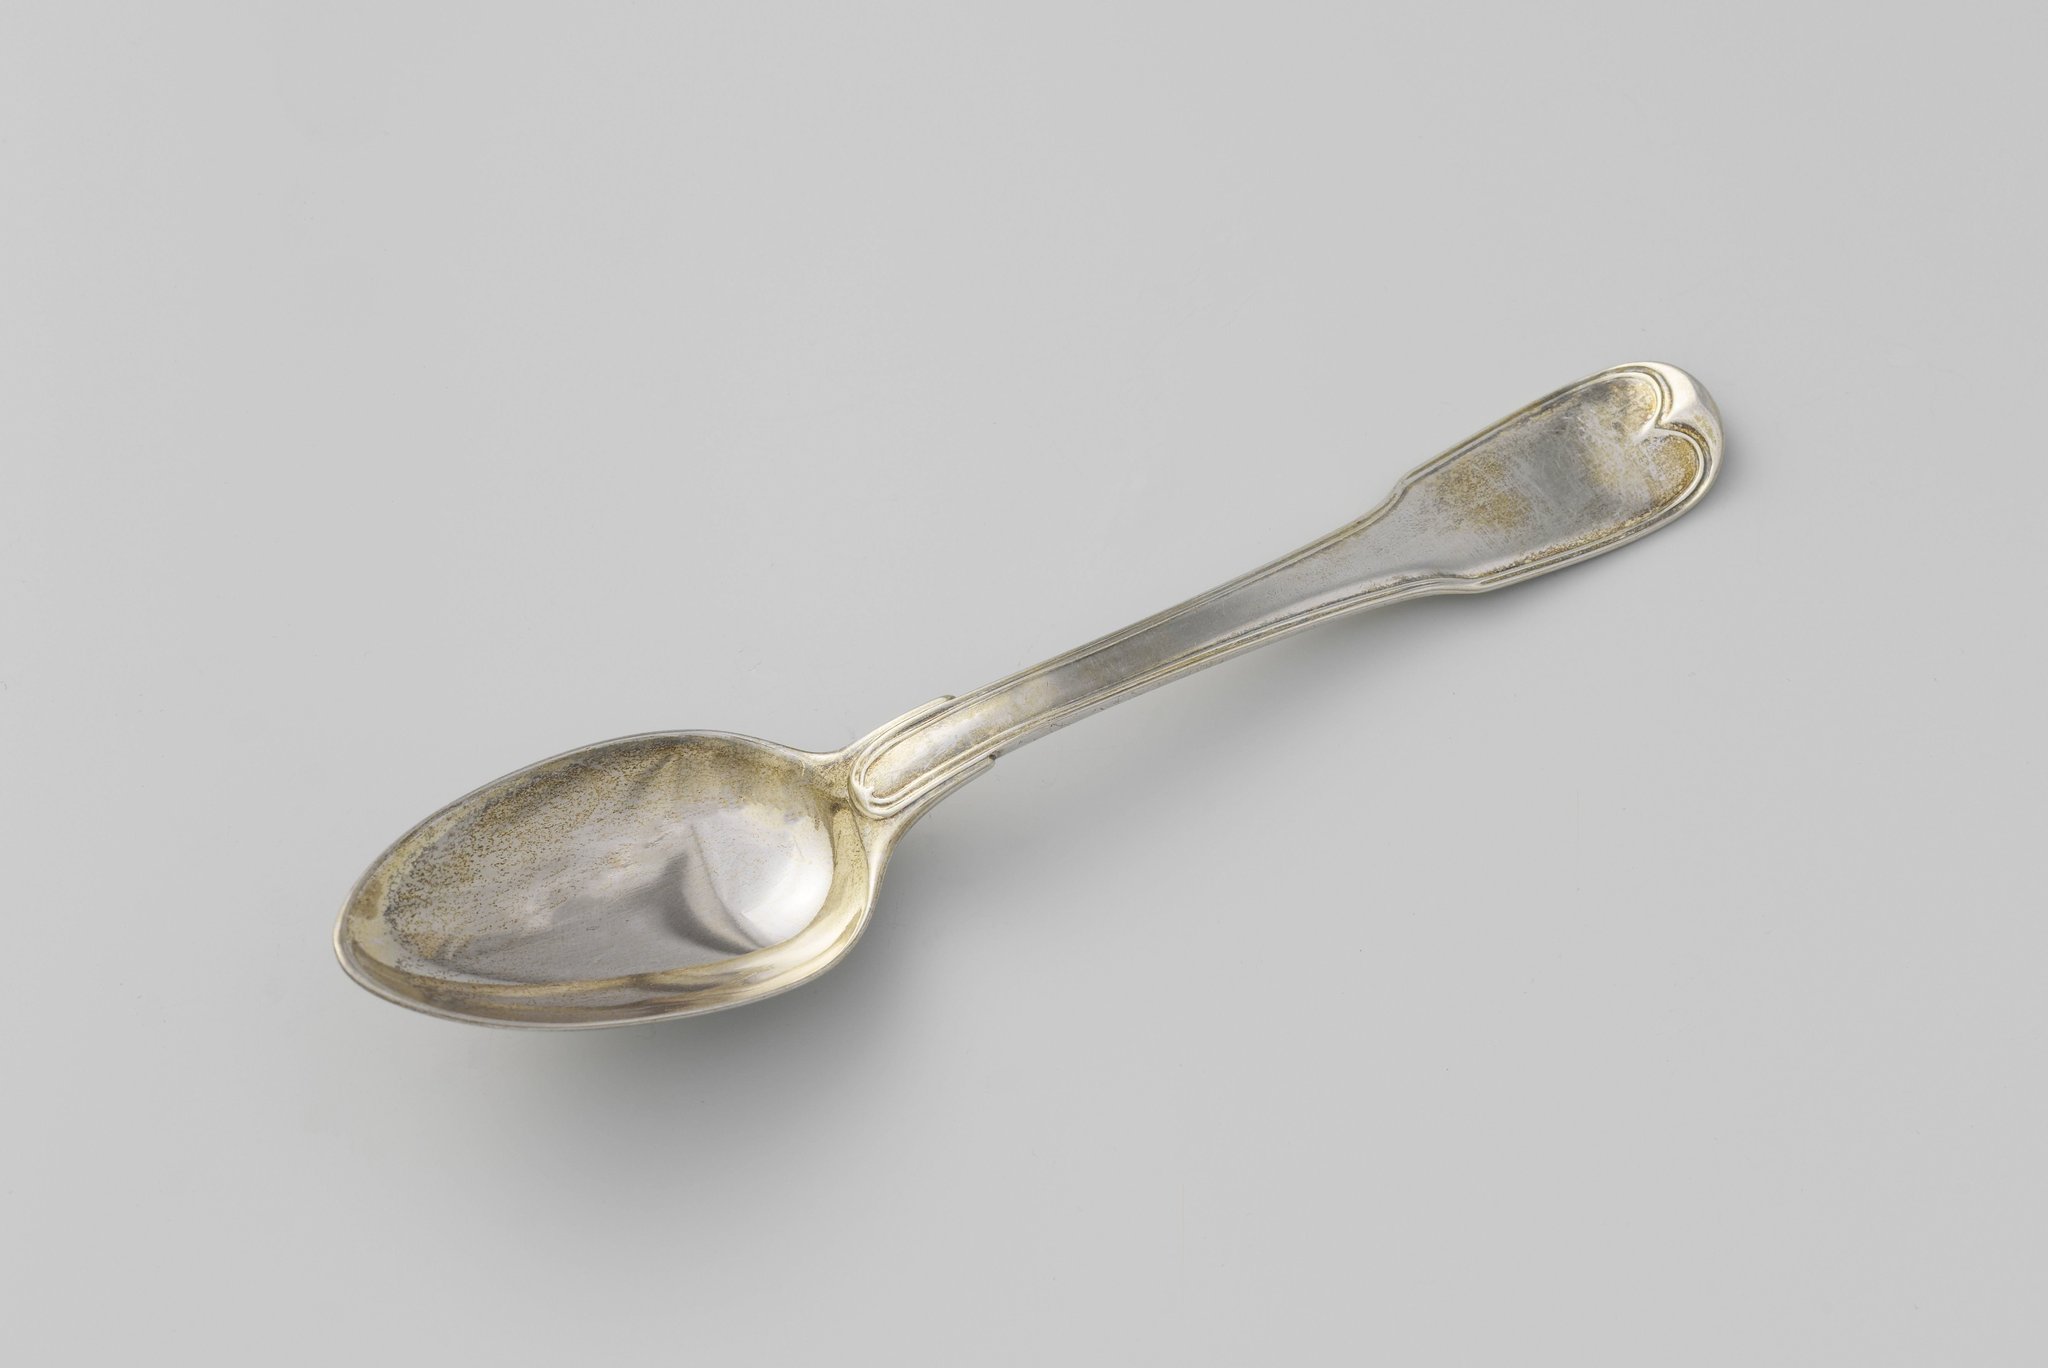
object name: spoon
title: Lepel met het helmteken Clifford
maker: roelof helweg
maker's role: silversmith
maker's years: 1758-1843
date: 1806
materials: silver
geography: amsterdam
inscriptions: date letter: ‘X (=1806)’, town mark: ‘Amsterdam’, maker's mark: ‘RH in ovaal’, alloy mark: ‘Hollandse leeuw’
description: De eivormige bak van de lepel is aan zowel boven- als onderzijde door middel van enkel lof verbonden met de platte, gebogen steel, die zich verbreedt naar het spatelvormige uiteinde. Boven- en onderzijde van de steel worden omgeven door een dubbele filetrand, die bij het uiteinde ingezwenkt is. Op de onderzijde van de spatel is het helmteken Clifford gegraveerd.